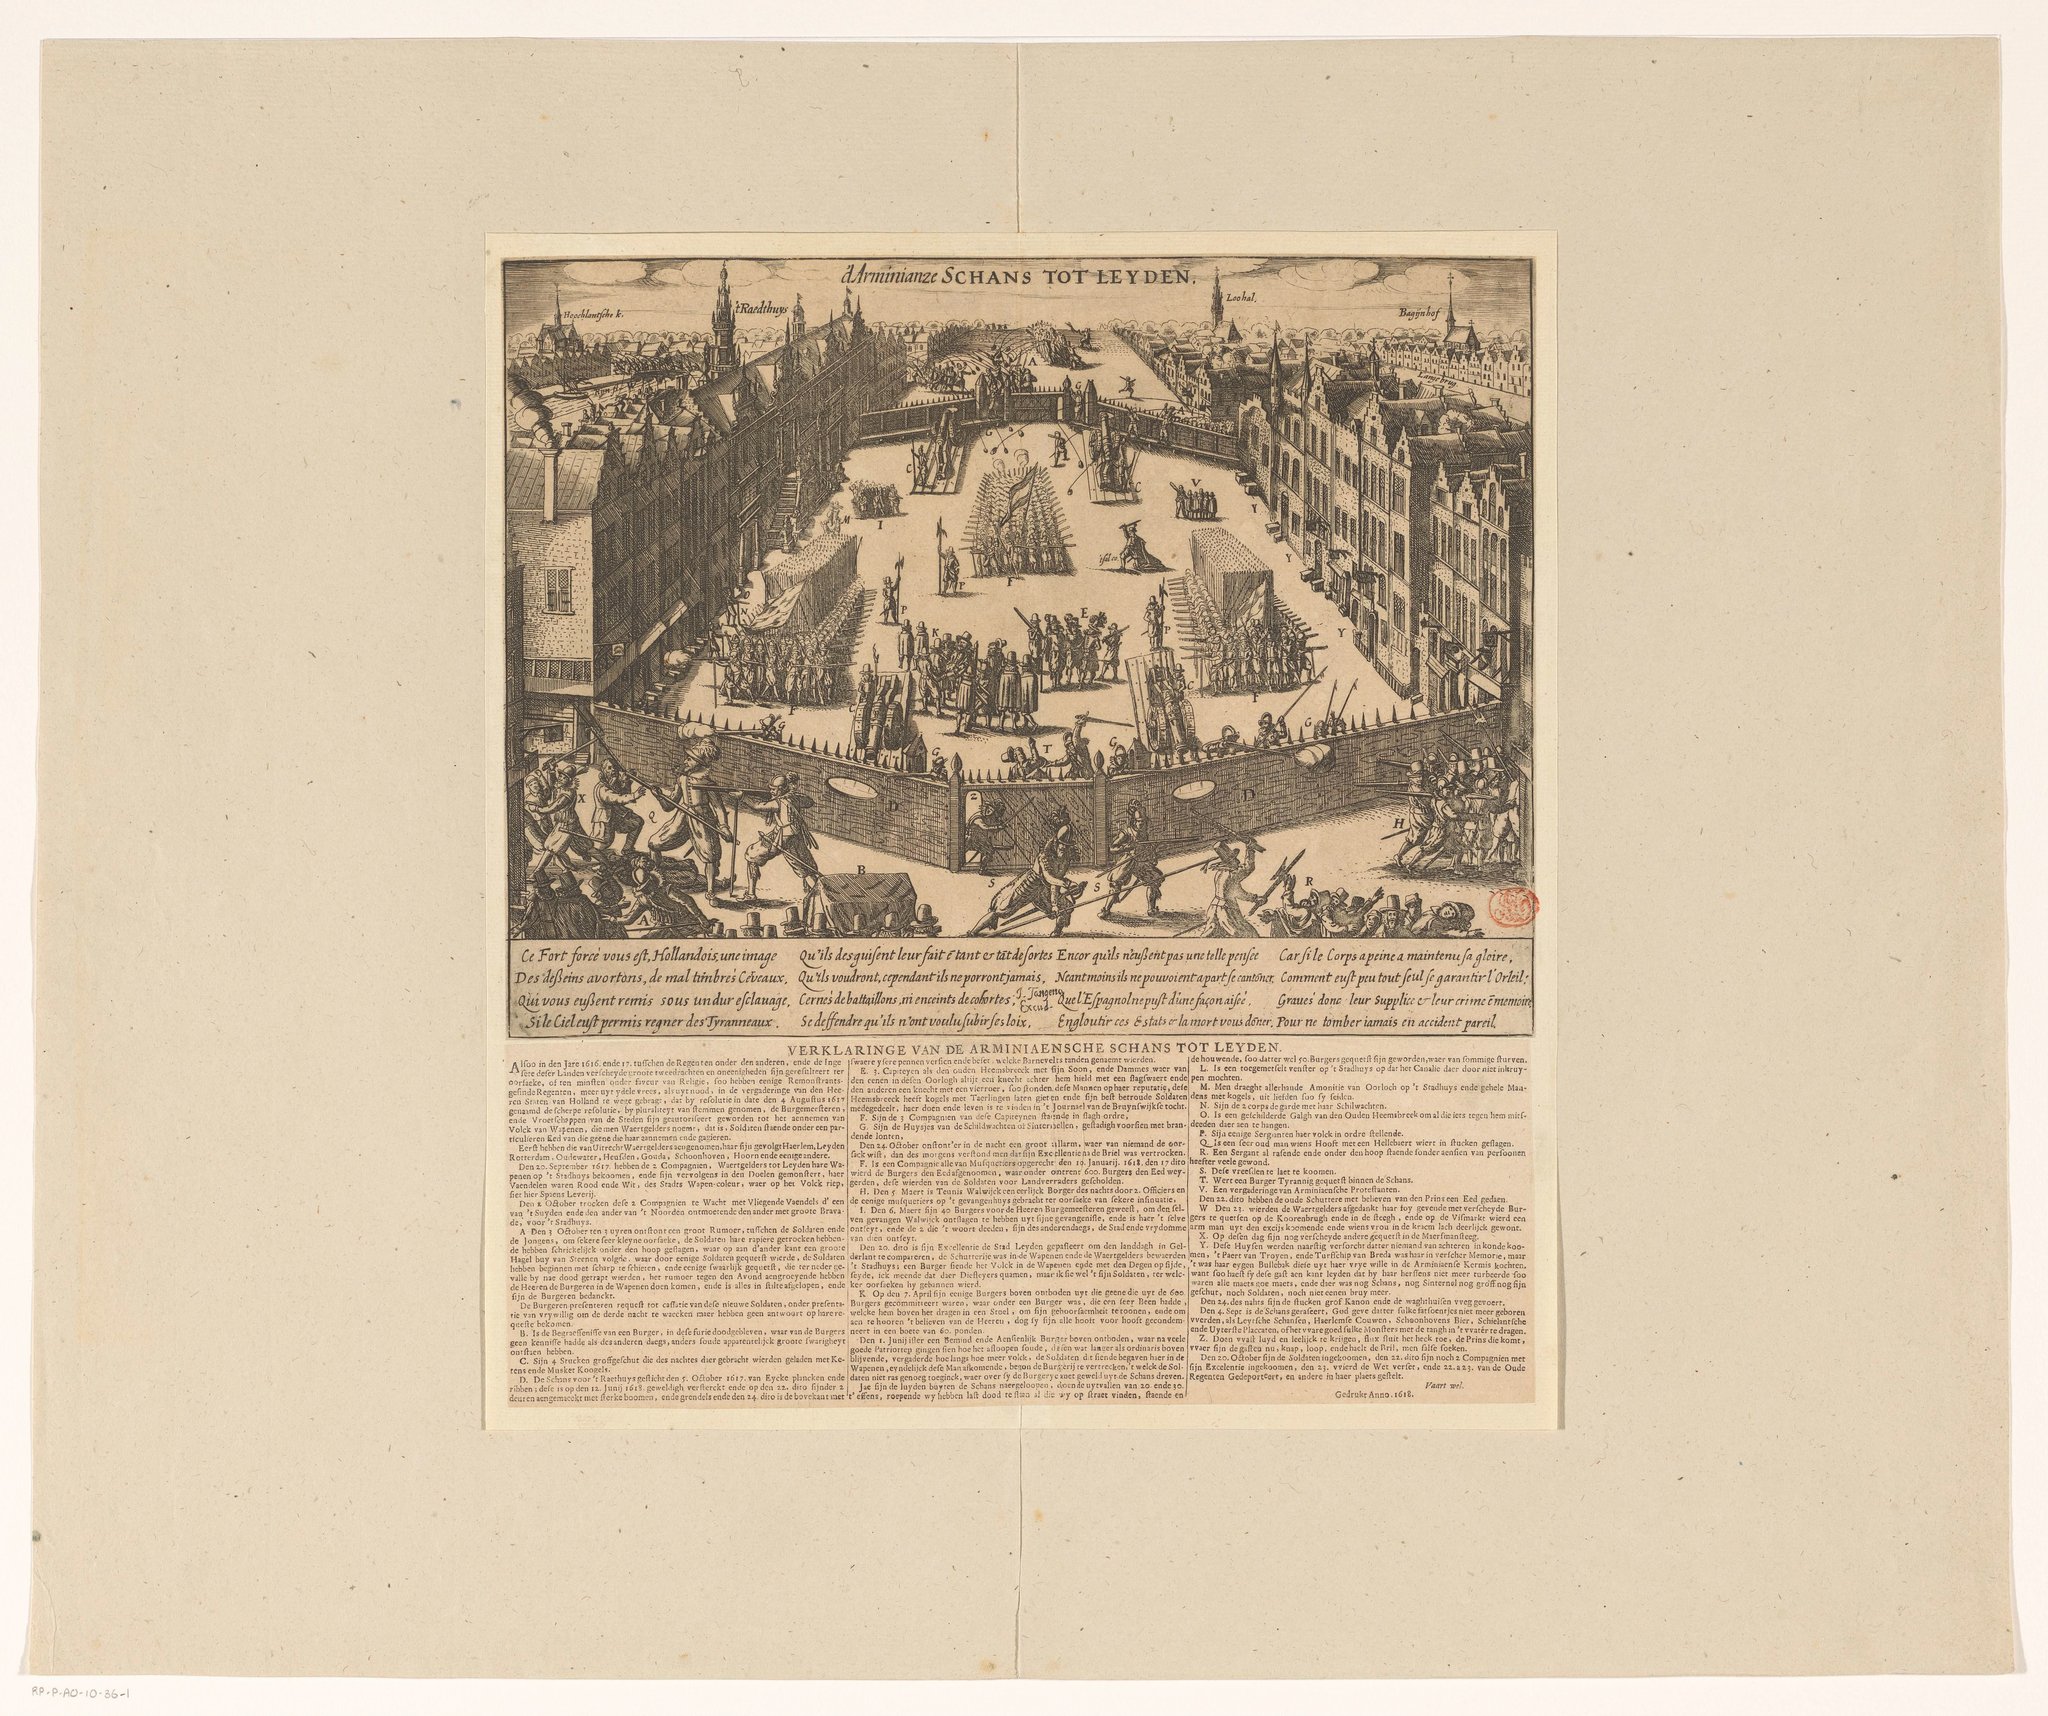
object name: print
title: De arminiaanse schans te Leiden, 1618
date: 1618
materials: paper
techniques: engraving, etching, letterpress printing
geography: leiden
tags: breestraat, arminiaanse schans te leiden, remonstranten en contraremonstranten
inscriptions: collector's mark: Lugt 195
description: Boven een blad met een voorstelling van de arminiaanse schans te Leiden. De schans werd op 5 oktober 1617 in de Breestraat bij het stadhuis opgericht om de remonstrants gezinde vroedschap en waardgelders te beschermen. De voorstelling toont de schermutselingen die in de omgeving van de schans plaatsvinden. In de plaat, onder de voorstelling, een Frans onderschrift in vier verzen van vier regels. Onder het bijhorende tekstblad met een Nederlands onderschrift van drie kolommen, met een beschrijving van de gebeurtenissen tot 20 oktober 1618 toen de schans is afgebroken en een verklaring van de letters in de voorstelling.